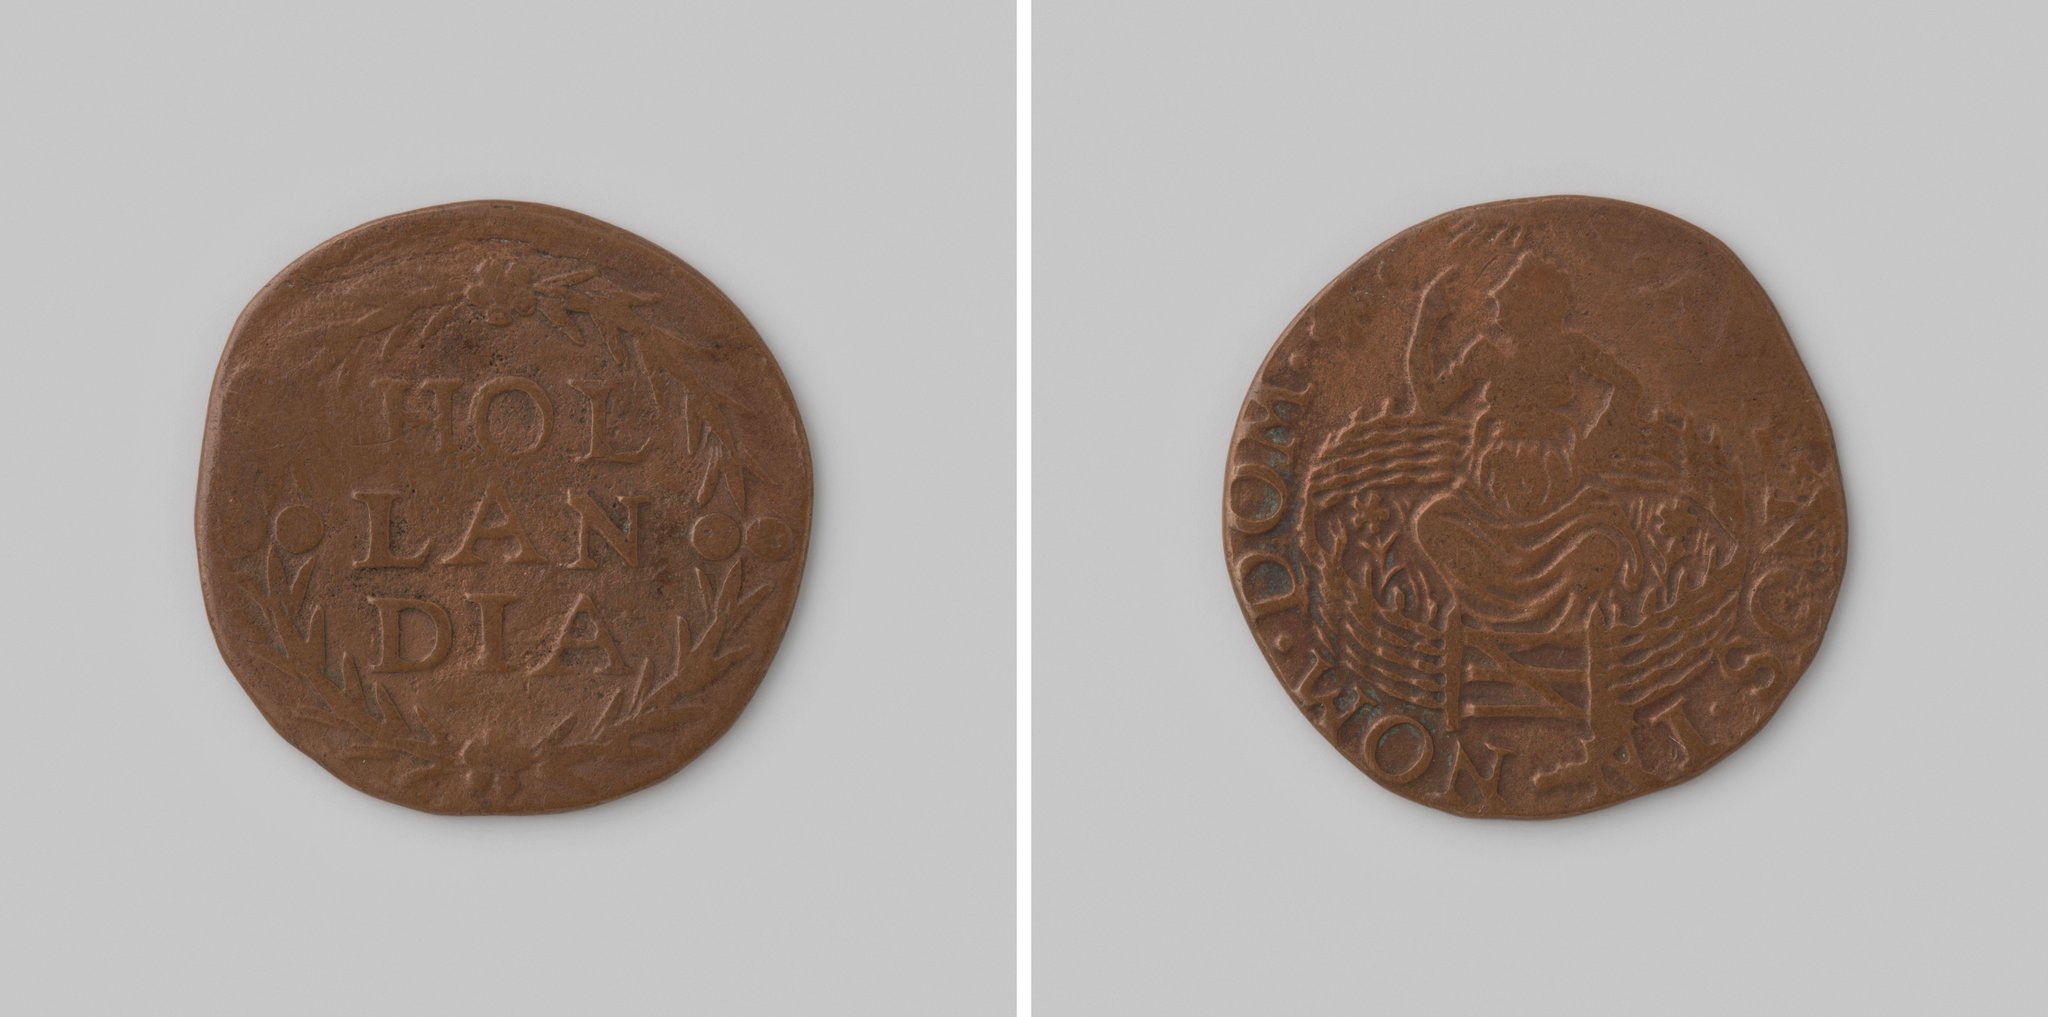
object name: coin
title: Holland, duit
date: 1590-1598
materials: copper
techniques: striking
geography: dordrecht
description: Koperen munt. Voorzijde: binnen lauwerkrans in drie regels opschrift HOL/LAN/DIA. Keerzijde: Hollandse maagd met opgestoken rechterarm, zittend in een tuin met gesloten omheining.